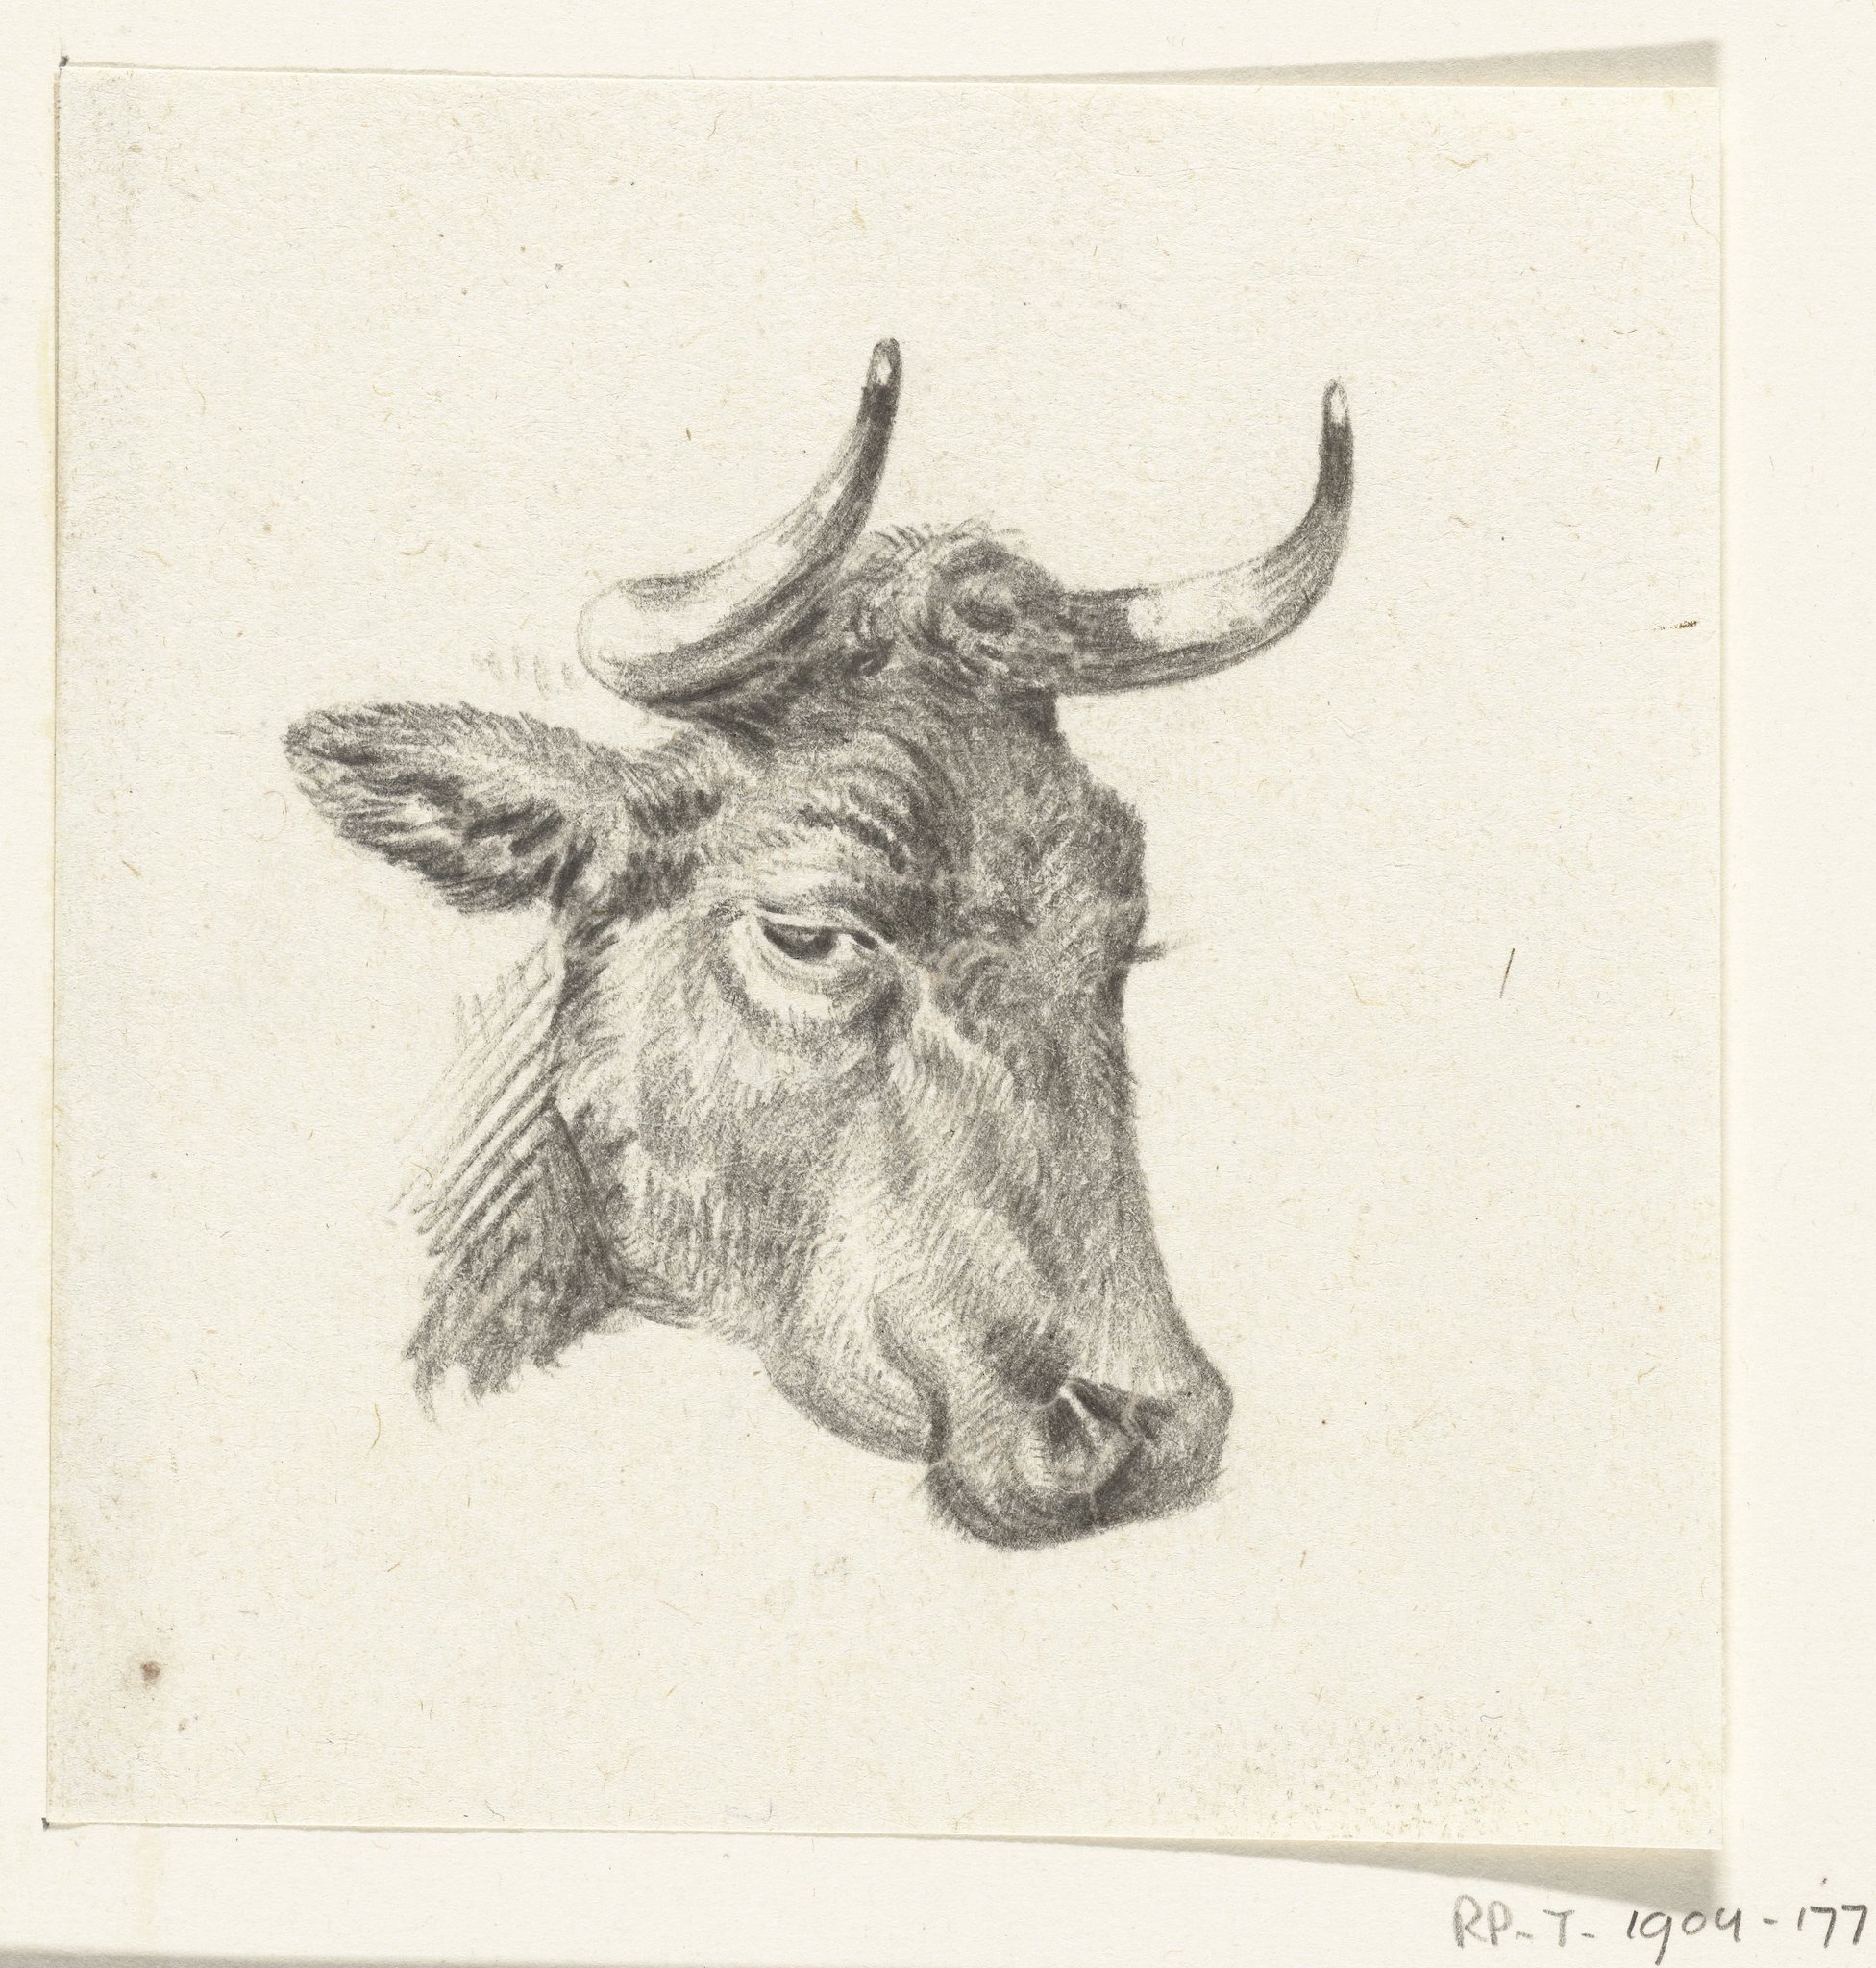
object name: drawing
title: Kop van een koe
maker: jean bernard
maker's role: draughtsman, print maker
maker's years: 1765-1833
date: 1775-1833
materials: chalk, paper, pencil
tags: cow